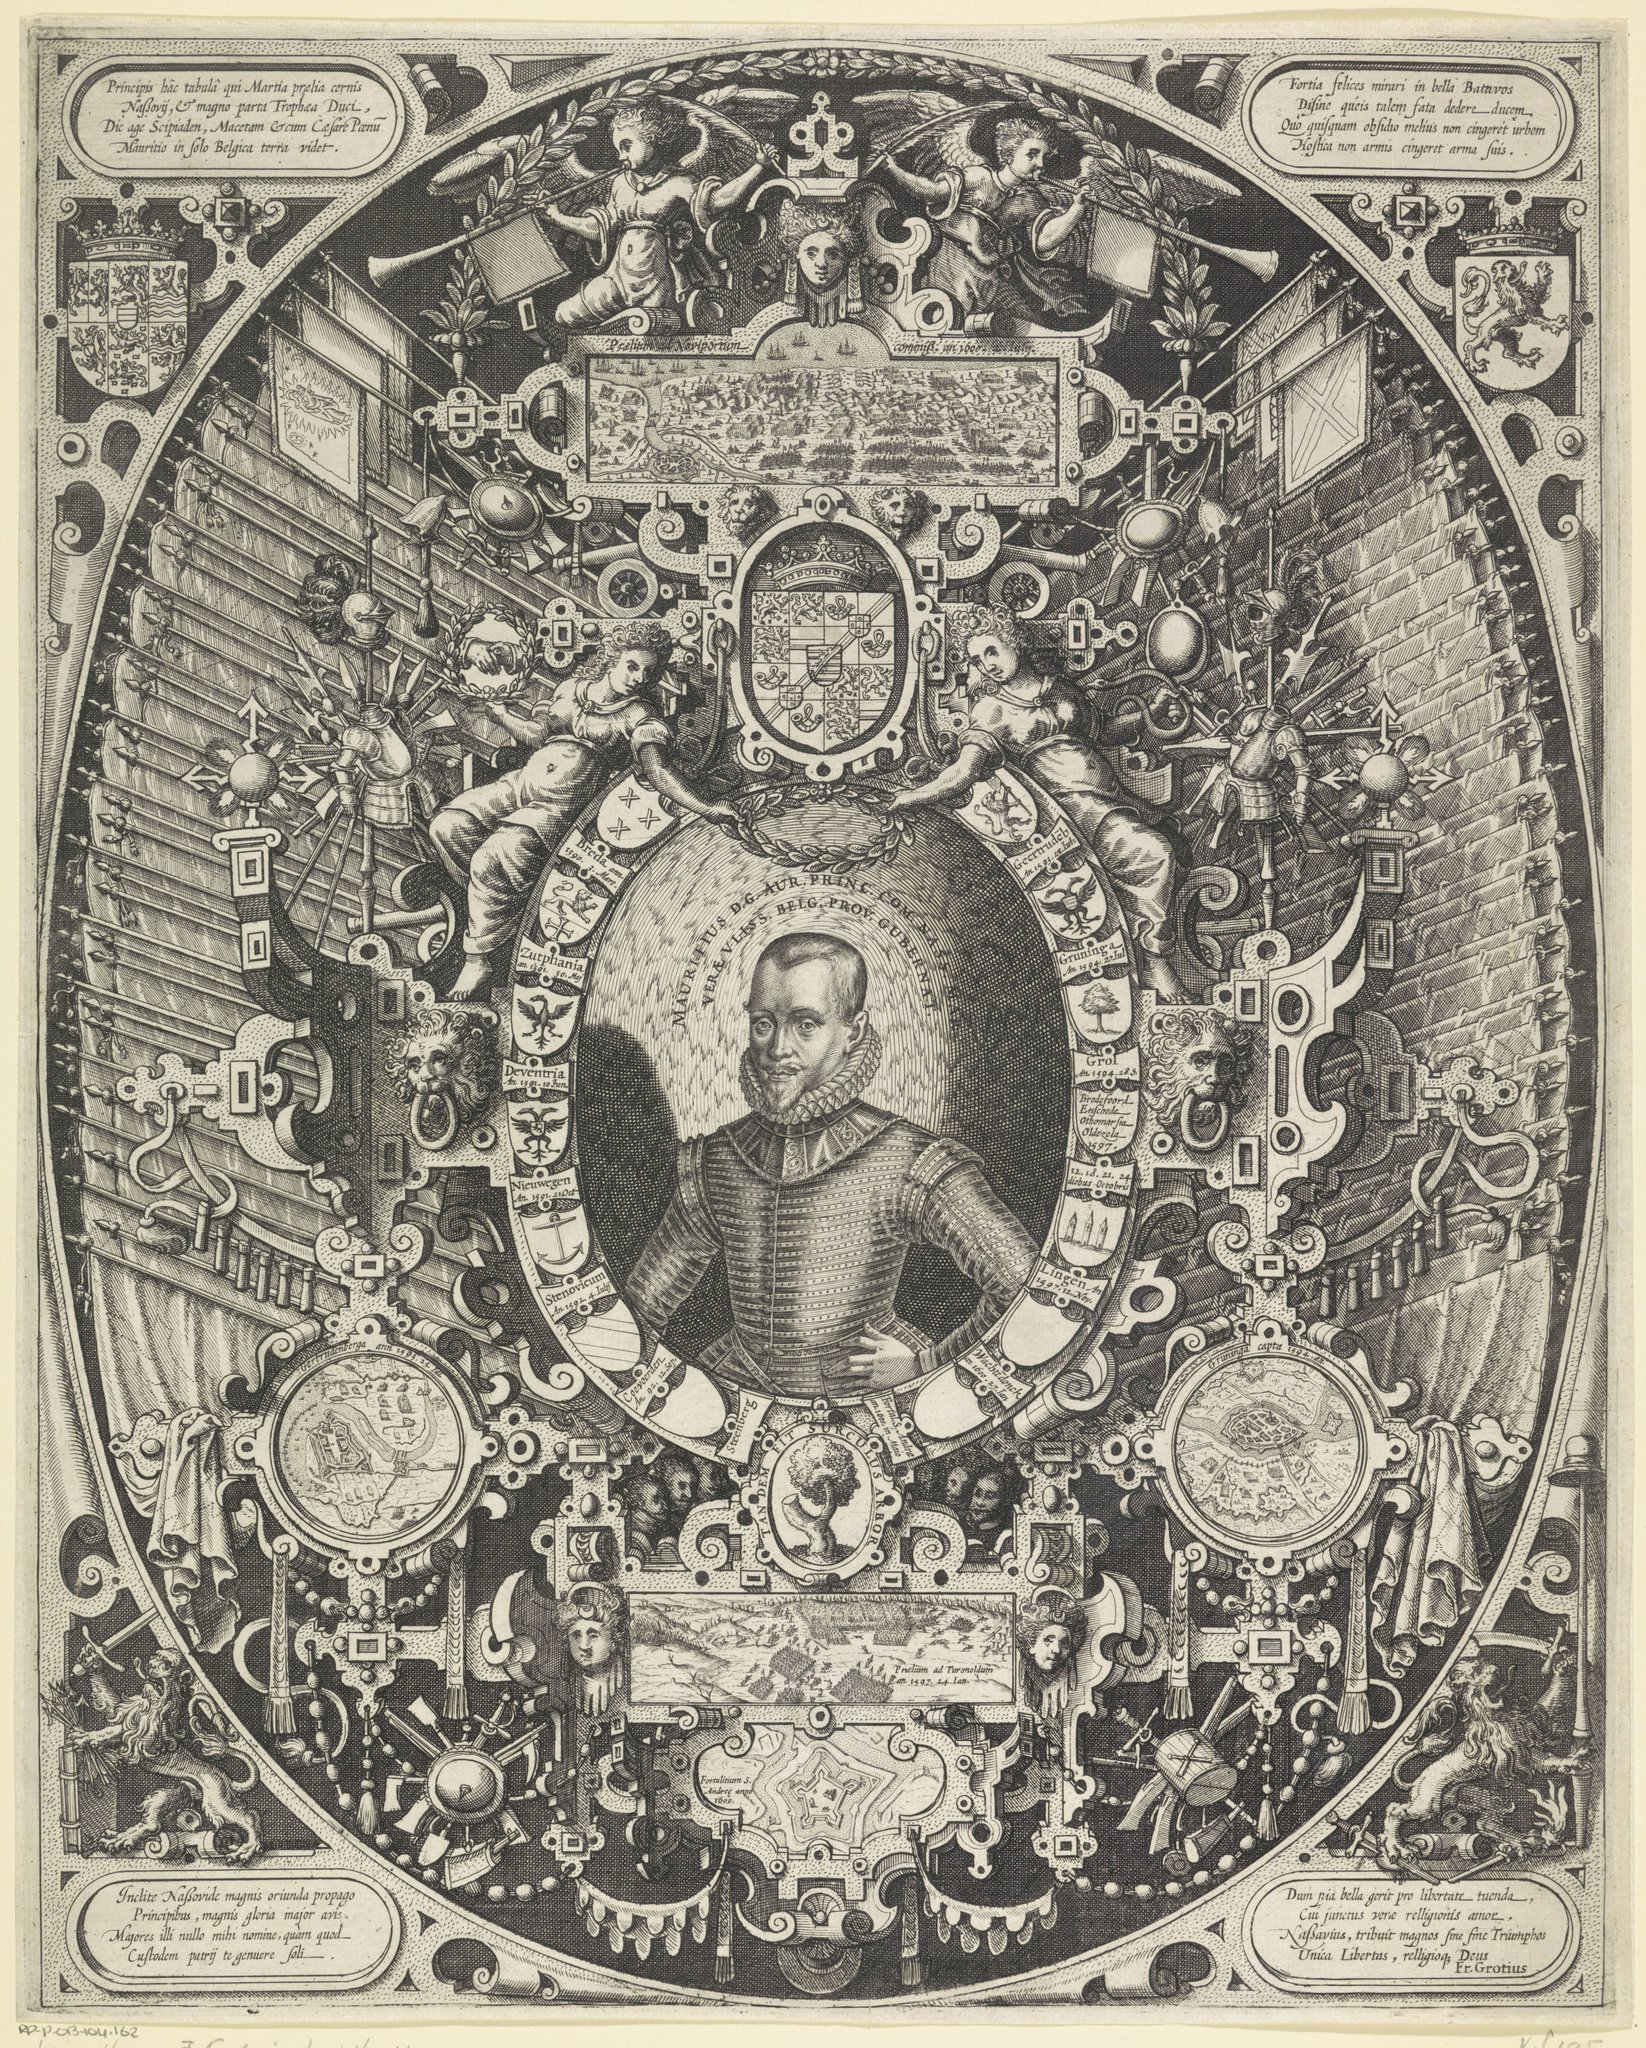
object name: print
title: Portret van Maurits, prins van Oranje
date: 1600-1602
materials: paper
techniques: engraving, etching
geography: northern netherlands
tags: maurice (prince of orange), precaution (+ abstract concept represented by female figure), uniformity (+ abstract concept represented by female figure), battle of nieuwpoort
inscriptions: collector's mark: Lugt 963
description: Portret van Maurits in een ovaal gevormd door wapens van veroverde plaatsen. Eendracht en Voorzichtigheid houden een lauwerkrans boven zijn hoofd. In vijf kleine scènes de veroveringen te Geertruidenberg (1593), Groningen (1594), Turnhout (1597), Sint-Andries (1600) en Nieuwpoort (1600). Verder rolwerk, wapentrofeeën en de buitgemaakte Spaanse vaandels. Onderaan links en rechts de Hollandse leeuw met links een pijlenbundel en rechts een zwaard en lans met vrijheidshoed. Verder ook de wapens van de prins en van de Staten-Generaal. In de vier hoeken vier regels Latijnse tekst.